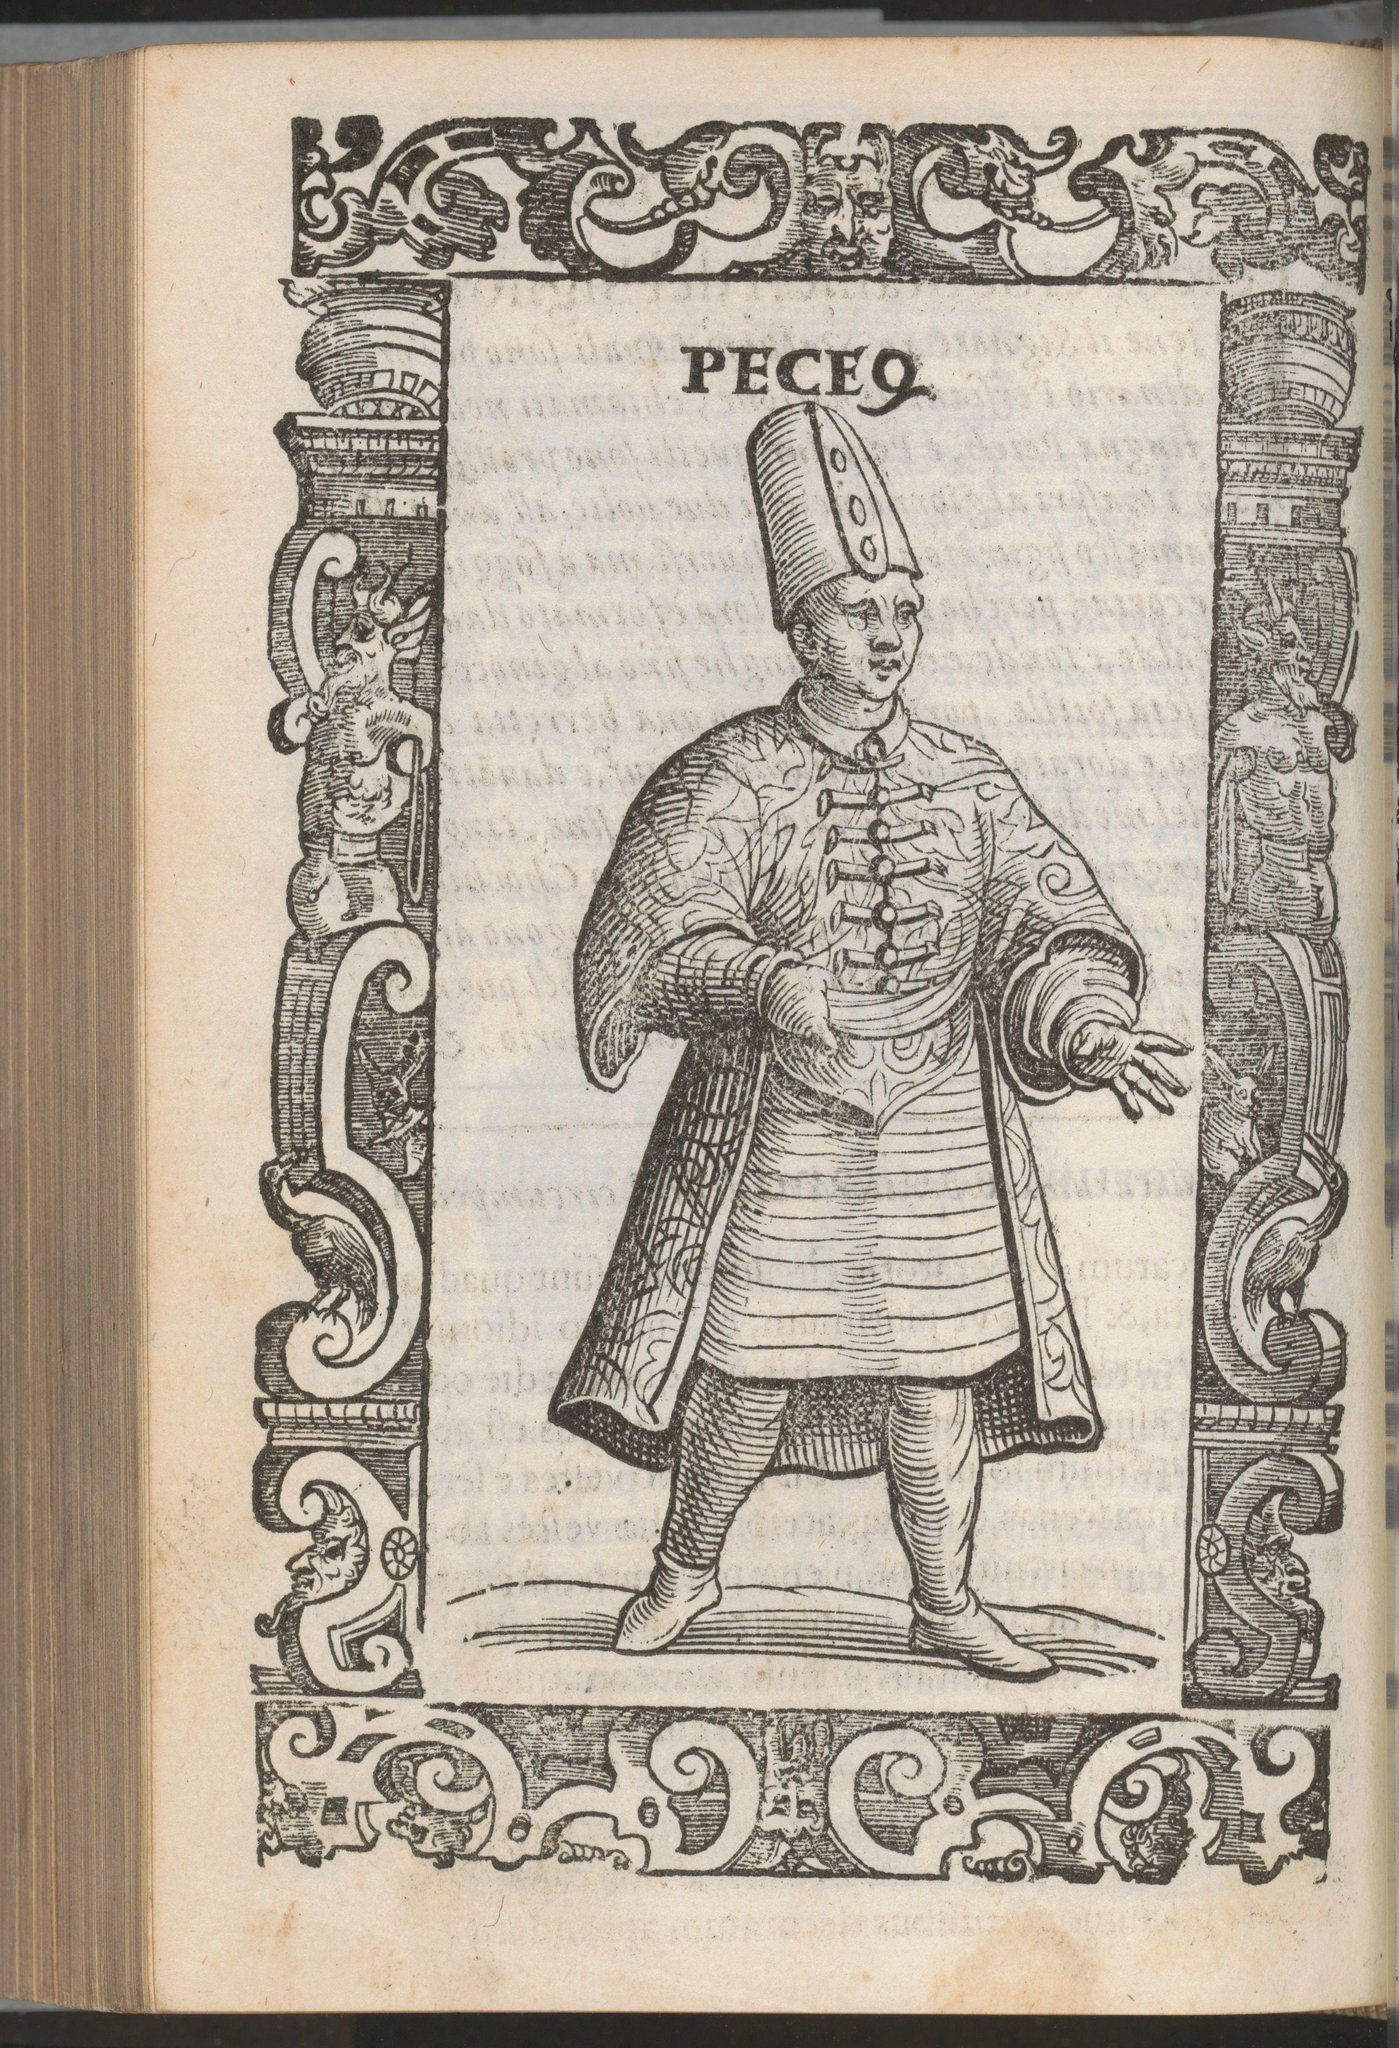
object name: costume print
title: Habiti antichi, et moderni di tutto il mondo...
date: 1598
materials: paper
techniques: woodcut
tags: fashion plates